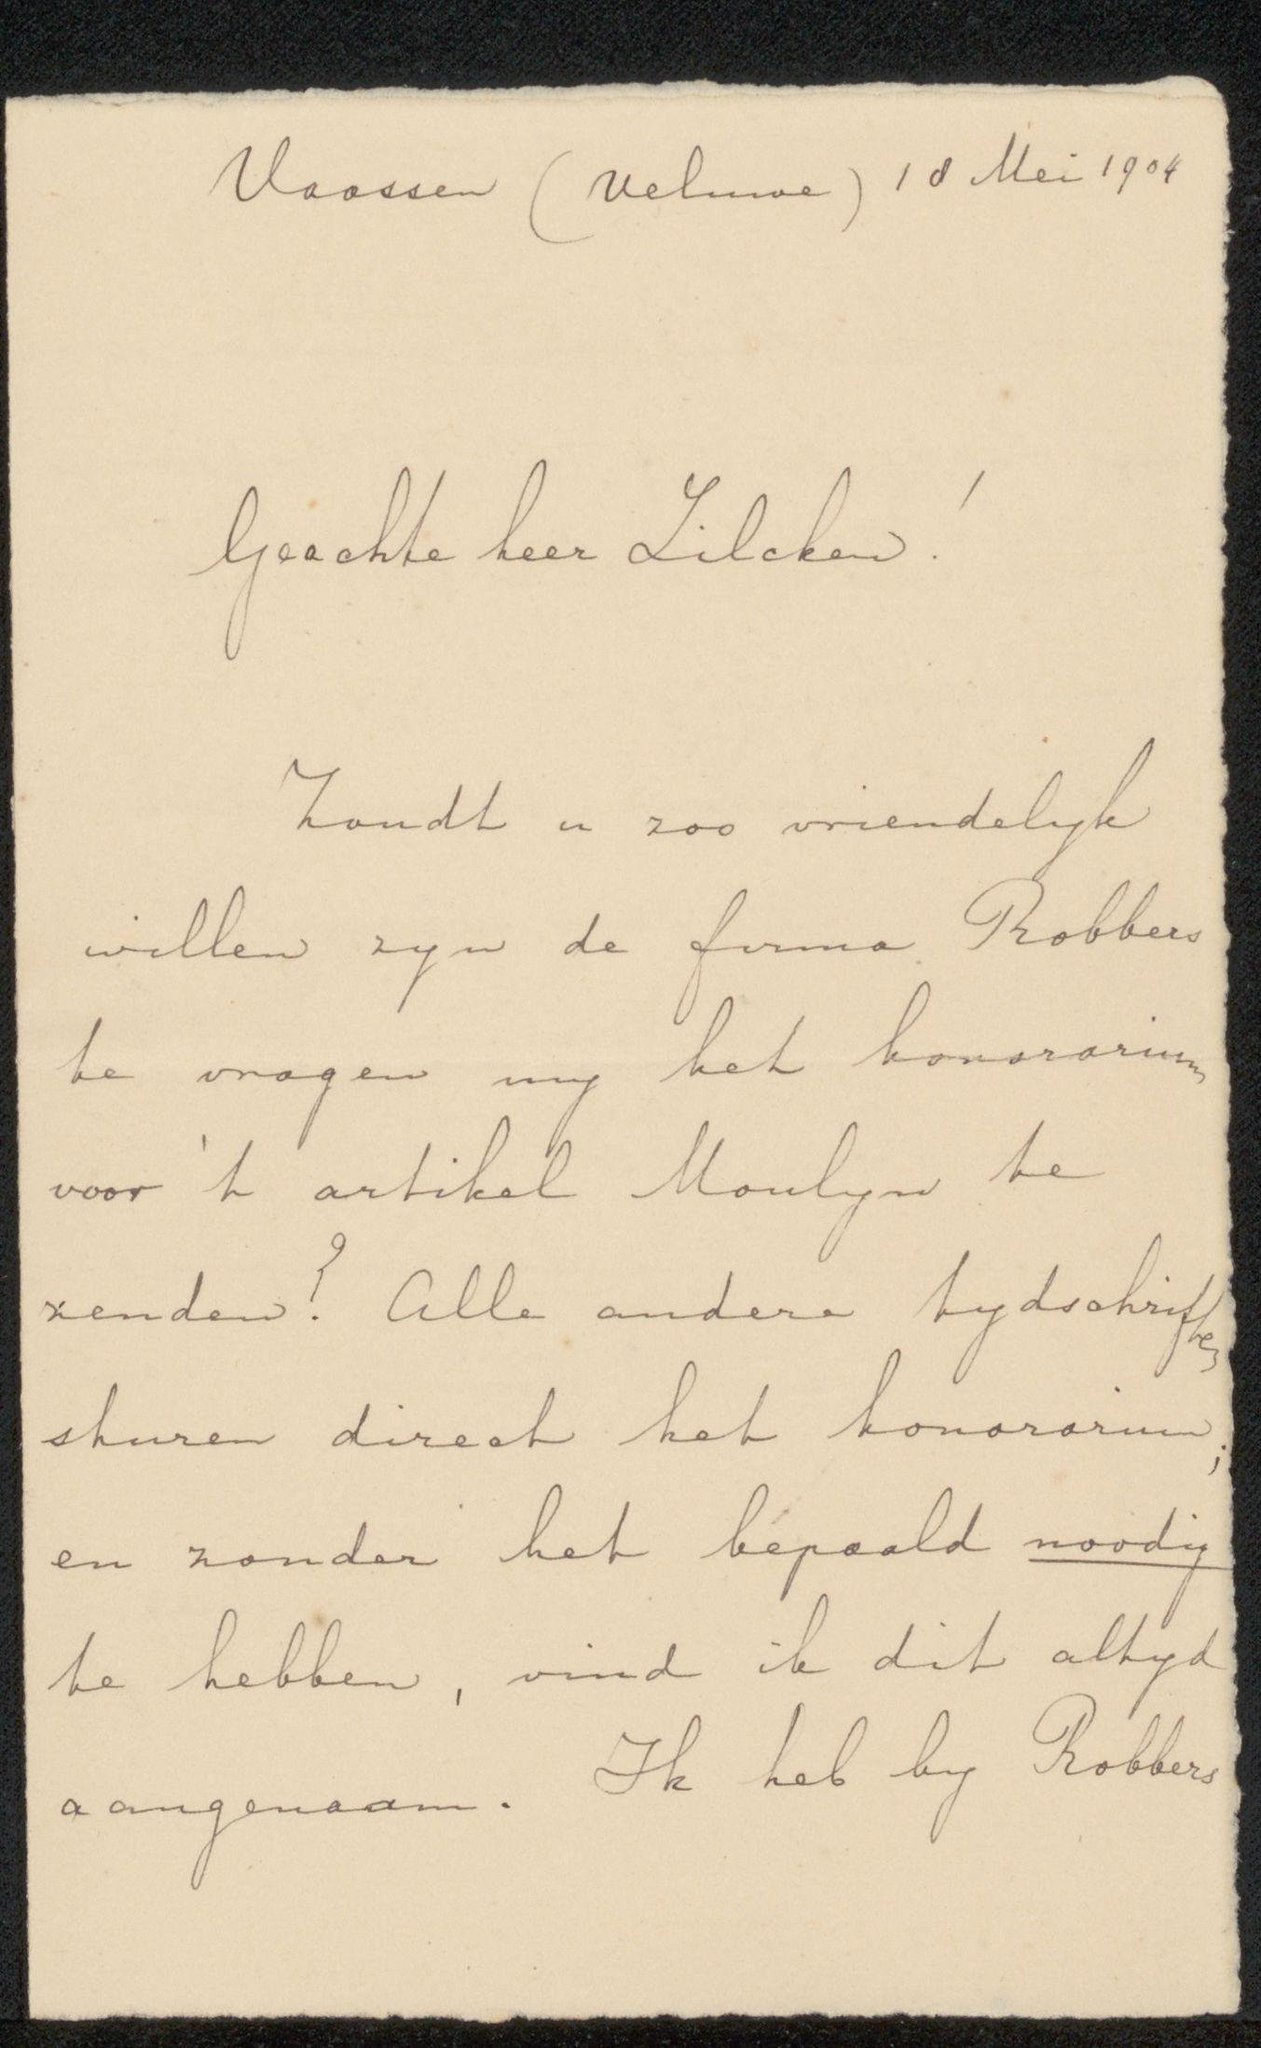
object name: letter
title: Brief aan Philip Zilcken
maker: marie metz-koning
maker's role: dichter, prozaschrijver, toneelschrijver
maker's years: 1864-1926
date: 1904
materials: ink, paper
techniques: pen, writing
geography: vaassen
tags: rotterdam, print maker, simon moulijn, the hague, painter, draughtsman, philip zilcken, money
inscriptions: collector's mark: ‘RPK’, watermark